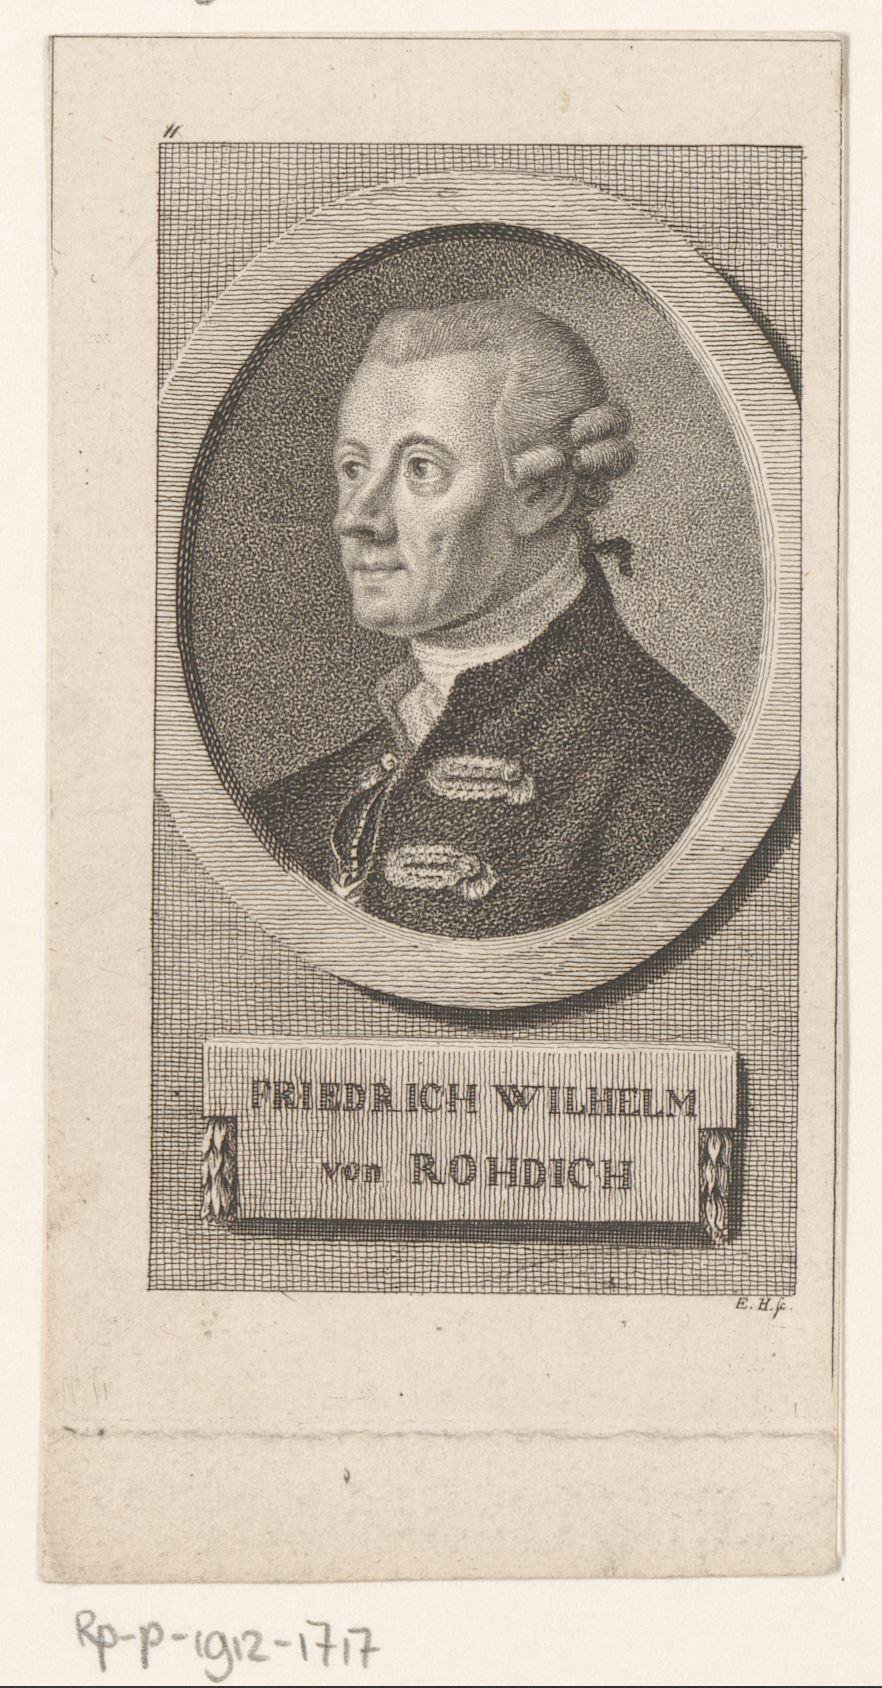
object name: print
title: Portret van Wilhelm von Rohdich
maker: eberhard siegfried henne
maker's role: print maker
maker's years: 1759-1828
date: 1769-1796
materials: paper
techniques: engraving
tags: commander-in-chief, general, marshal, historical persons, medals and other marks of military honour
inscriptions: collector's mark: Lugt 2228